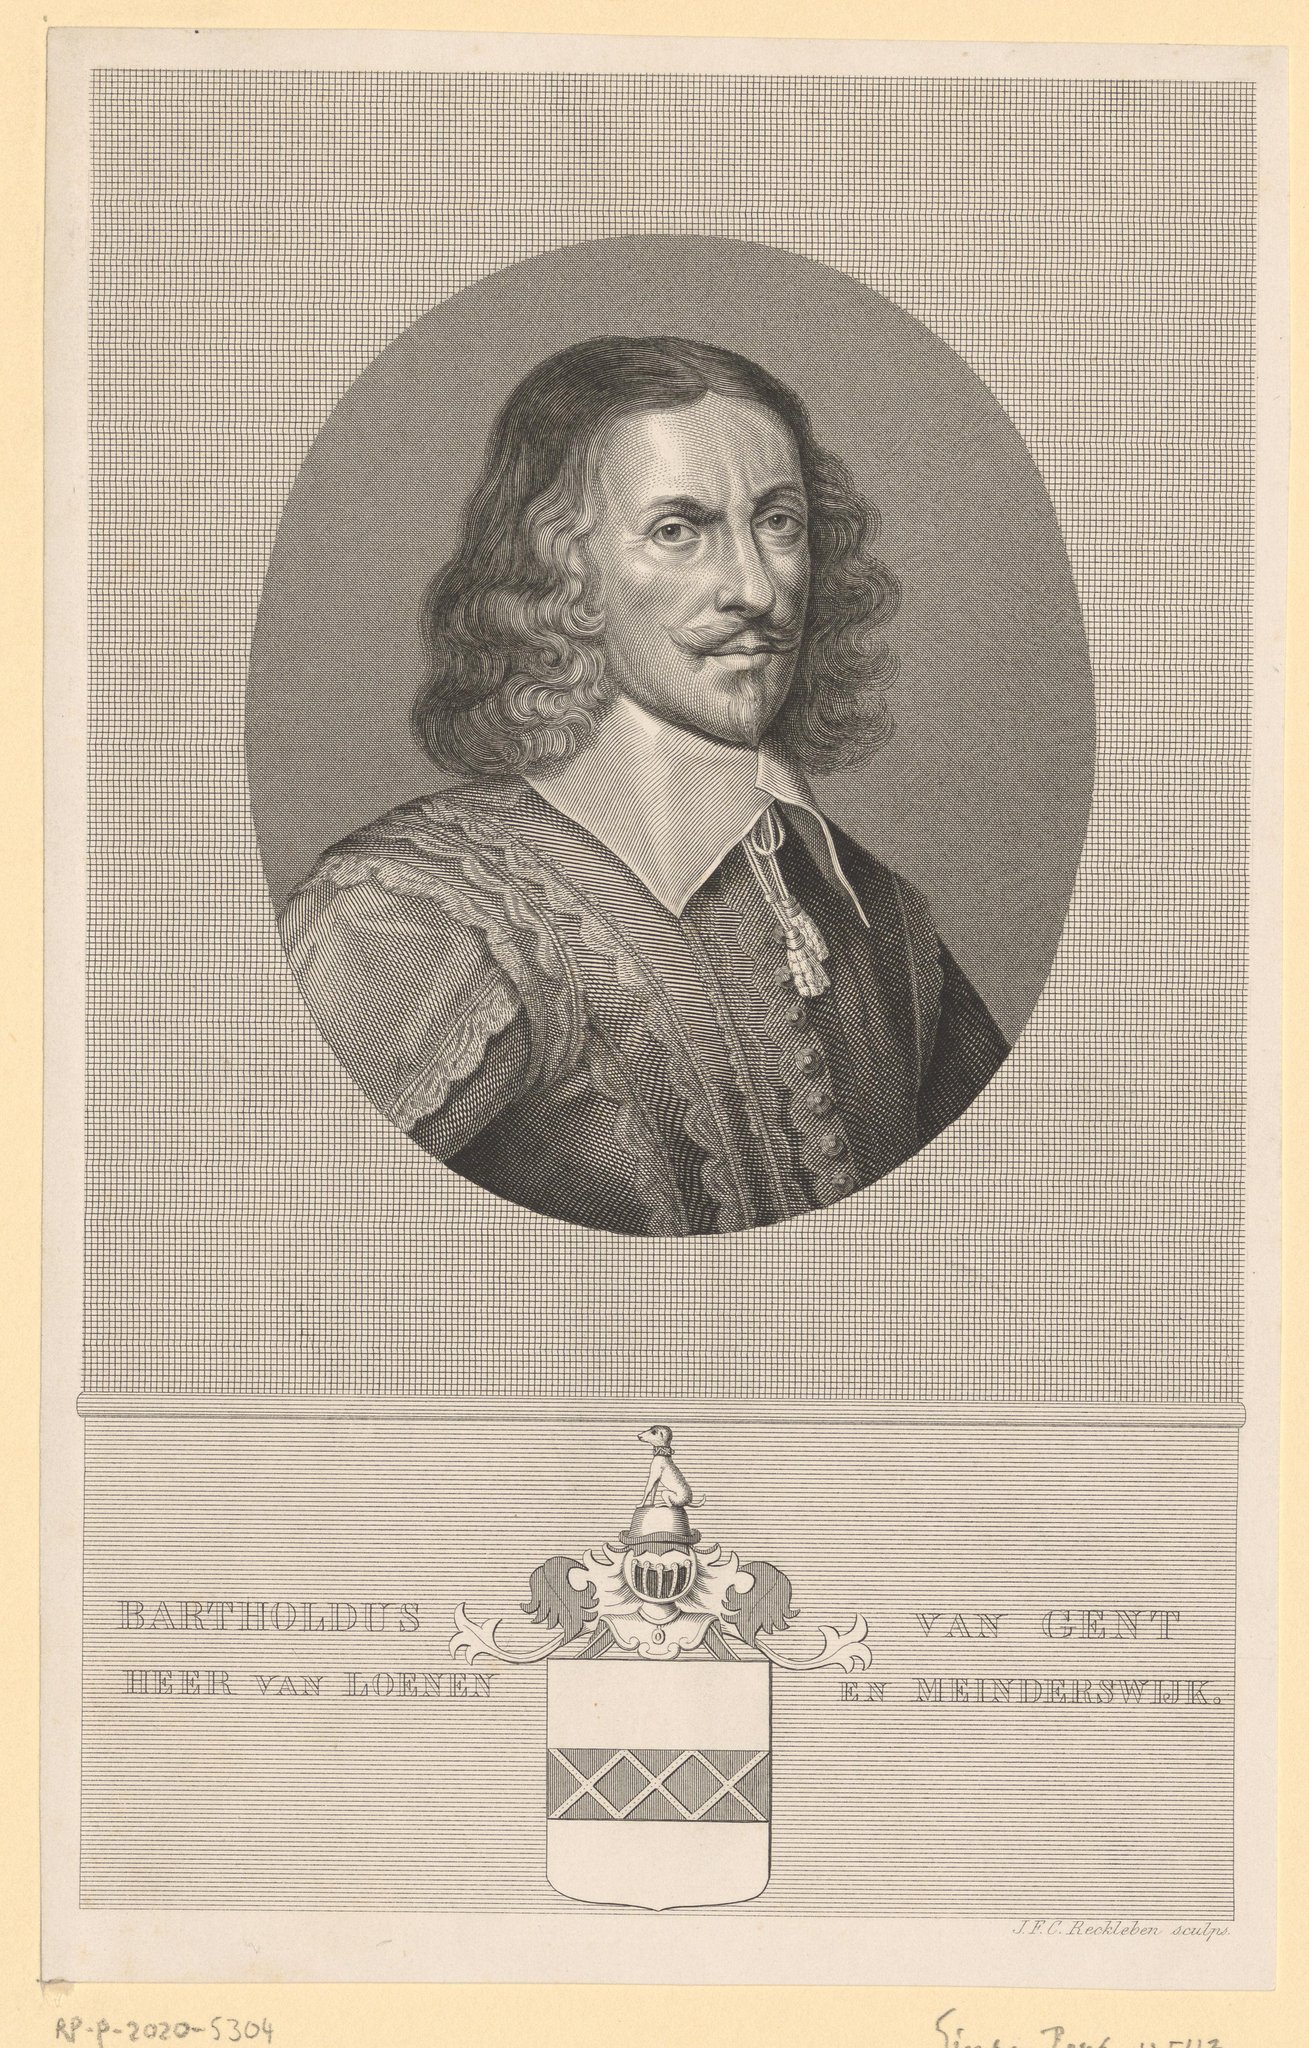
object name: book illustration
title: Portret van Barthold van Gent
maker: jan frederik christiaan reckleben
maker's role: print maker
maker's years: 1819-1879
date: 1868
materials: paper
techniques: engraving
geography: amsterdam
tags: historical persons, politician, e.g. party leader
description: Prent uit: Arend, Johannes Pieter. Algemeene geschiedenis des vaderlands van de vroegste tijden tot op heden. Amsterdam: C.L. Schleijer & Zoon, 1868, dl. 4, p. 423.